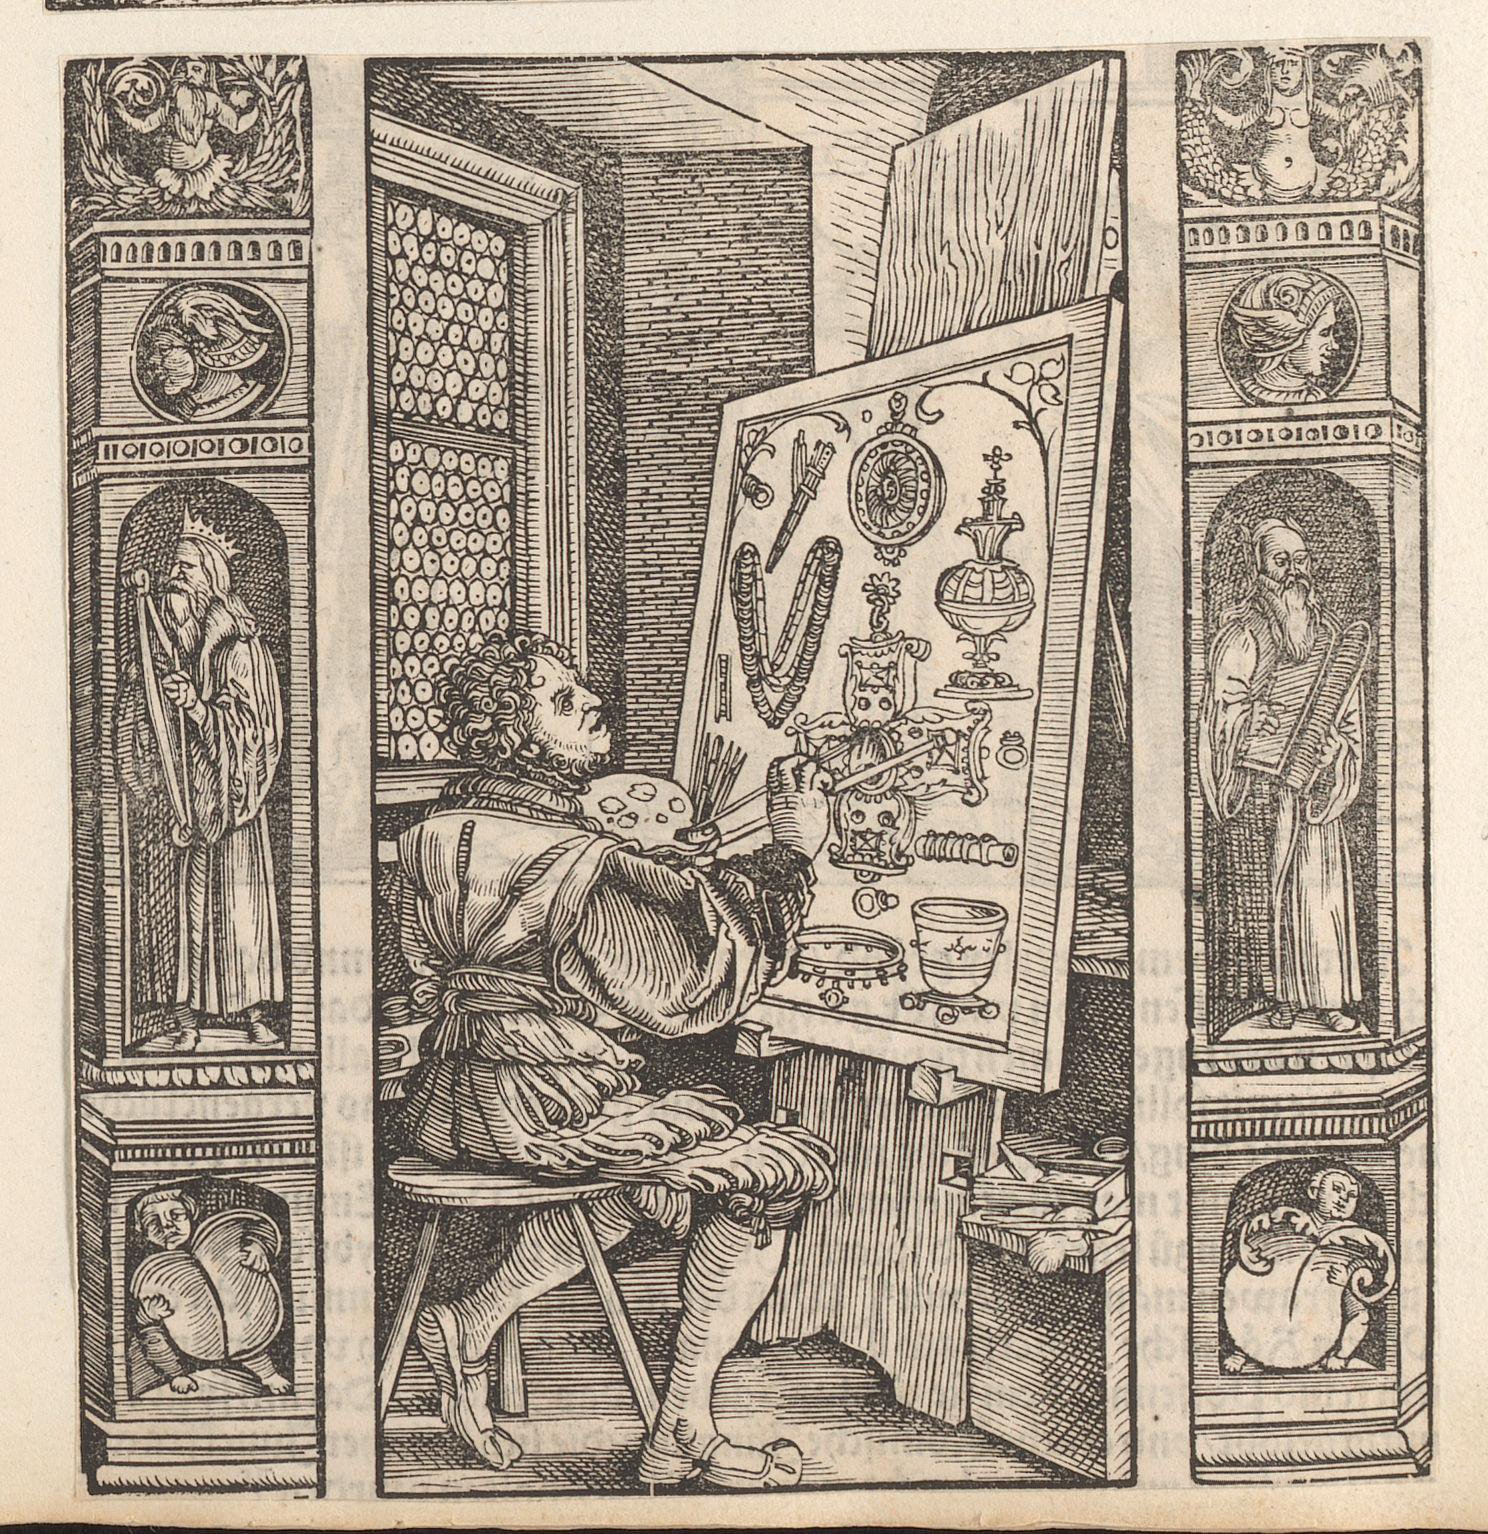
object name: book illustration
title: Schilder aan het werk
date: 1514-1531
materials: paper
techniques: letterpress printing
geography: augsburg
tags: merman - aa - mermaid, siren, painter at work, in his studio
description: Deze prent is gebruikt in: Cicero, Marcus Tulius. Officia M.T.C. Ein Buch so Marcus Tullius Cicero der Römer zu seynem (...). [Vertaald uit het Latijn door] Johann von Schwarzenberg. Augsburg: Heinrich Steiner, 1531.